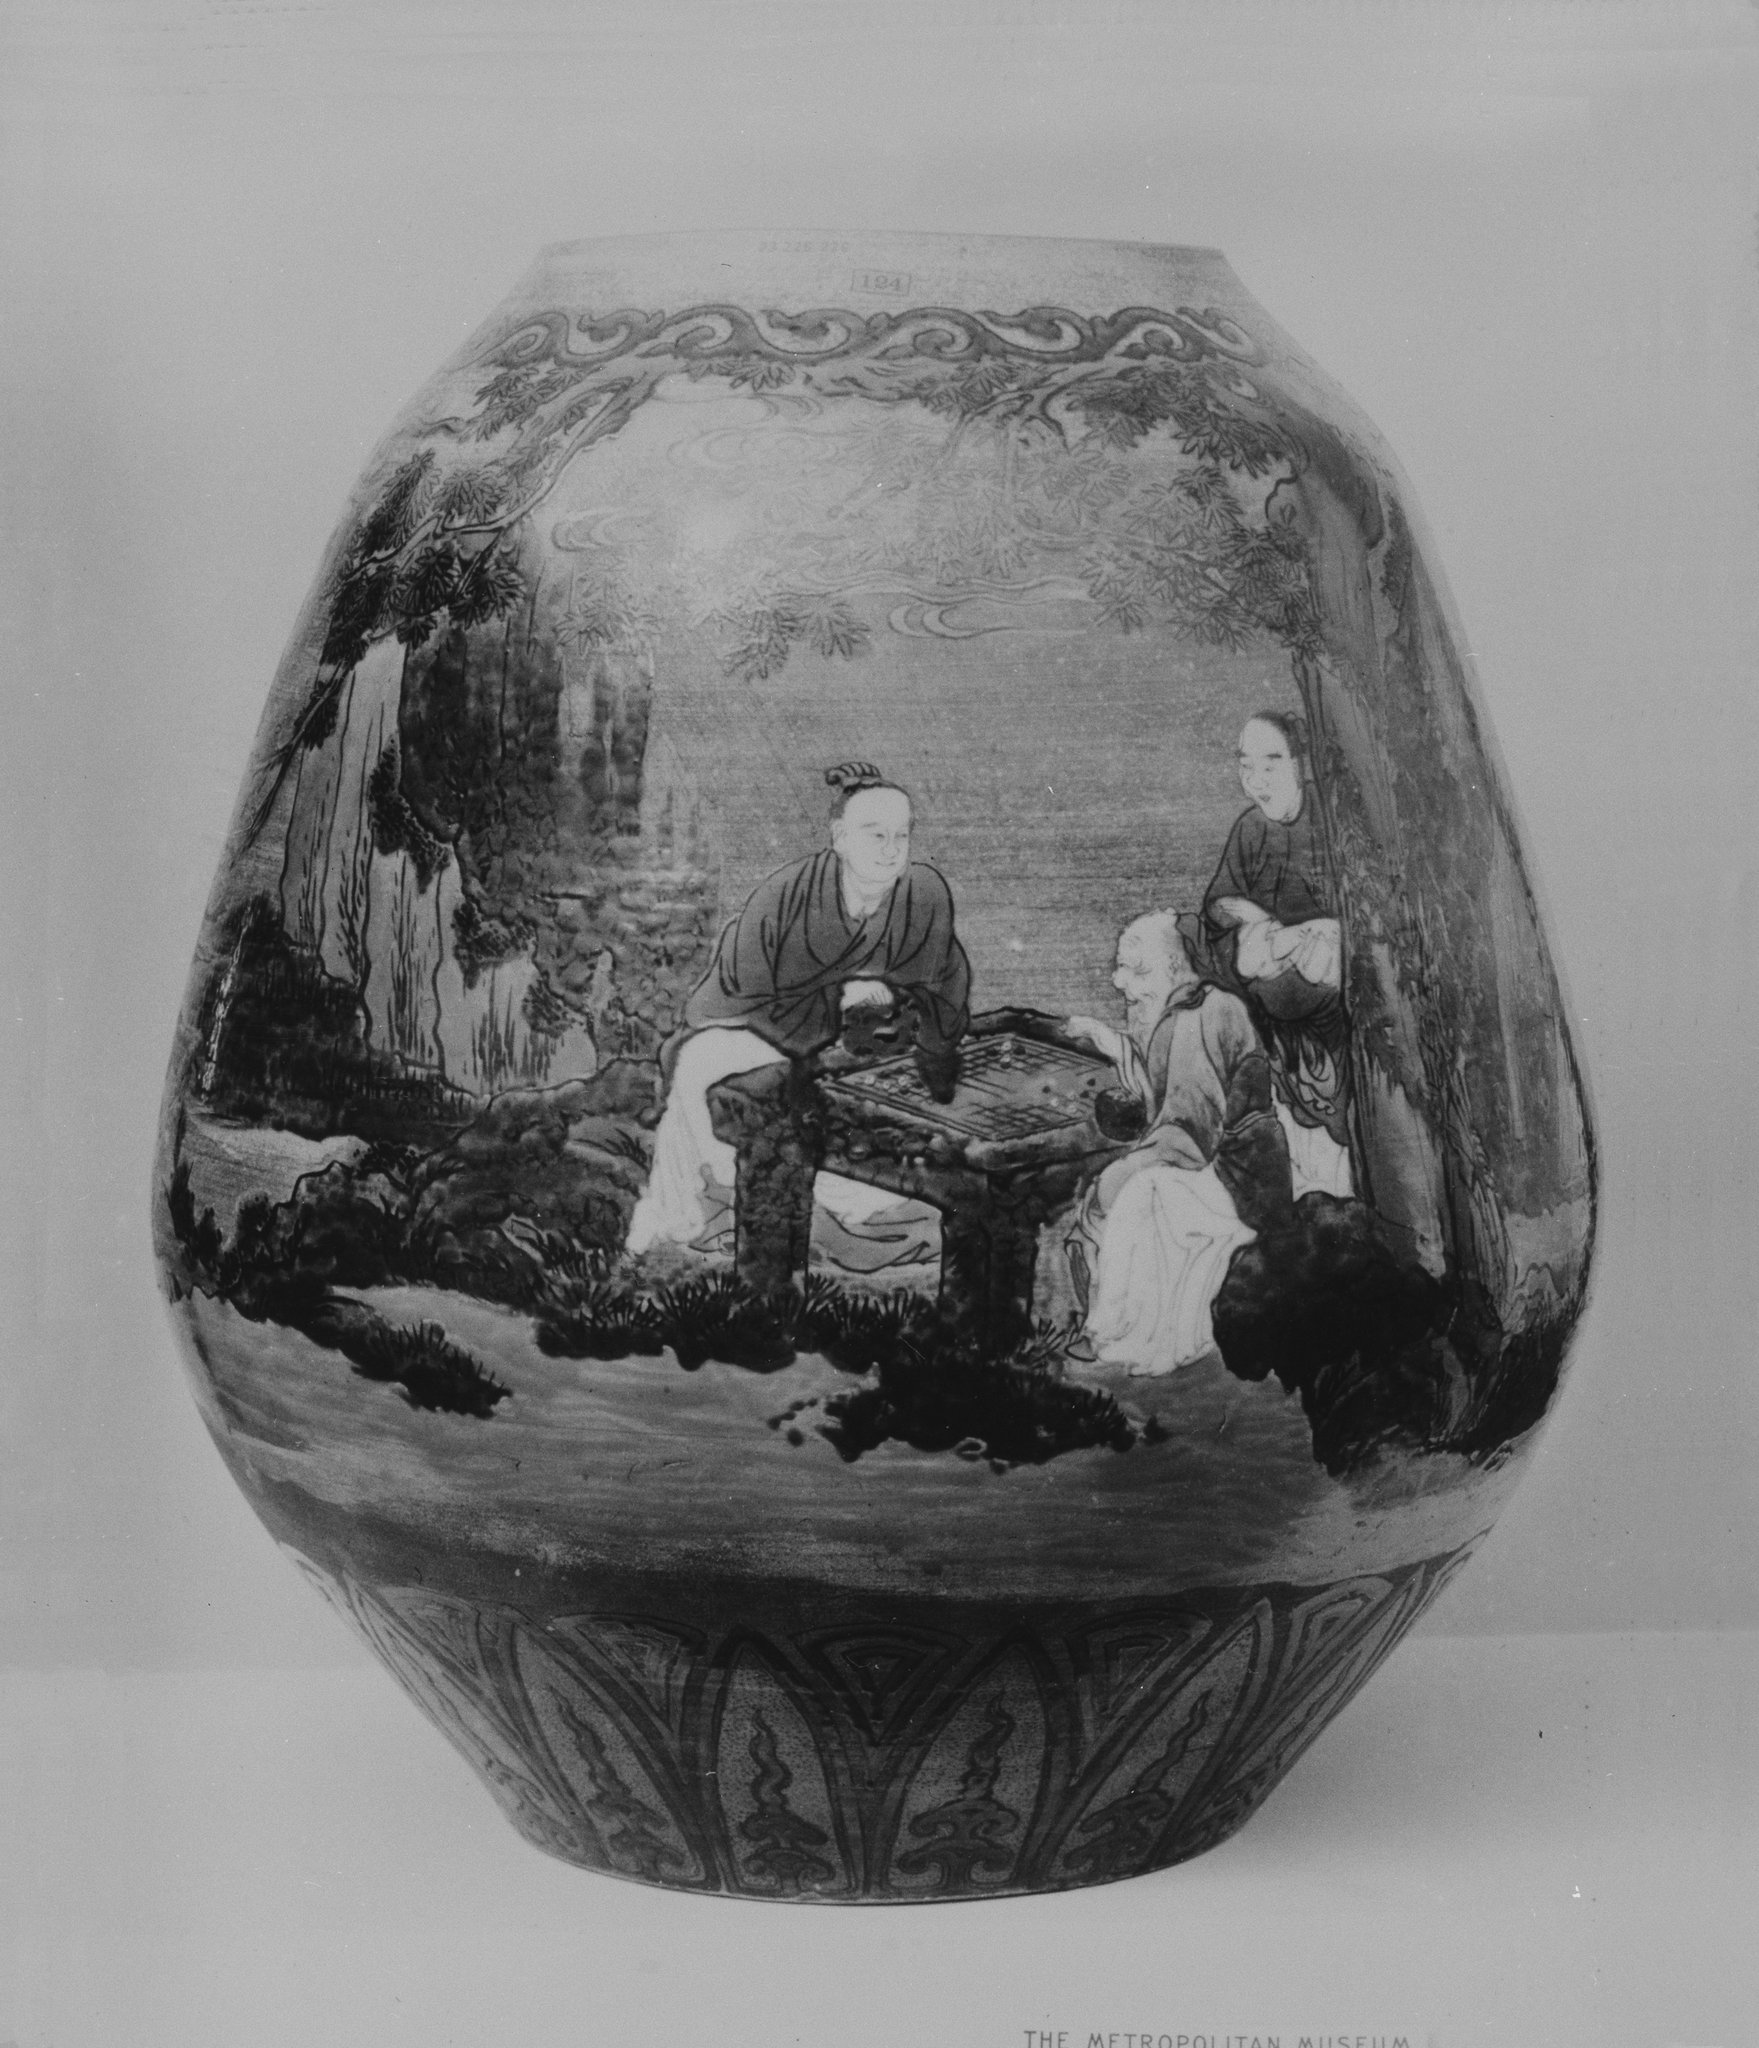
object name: vase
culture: japanese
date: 1830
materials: enamel, porcelain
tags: men